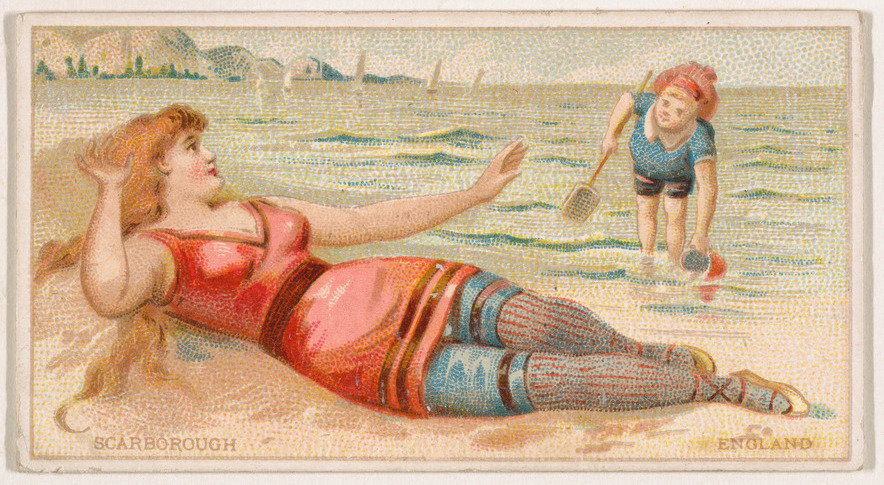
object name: print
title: Scarborough, England, from the Surf Beauties series (N232), issued by Kinney Bros.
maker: kinney brothers tobacco company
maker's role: publisher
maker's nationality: american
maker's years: 1869-2011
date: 1889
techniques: color lithograph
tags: profiles,women